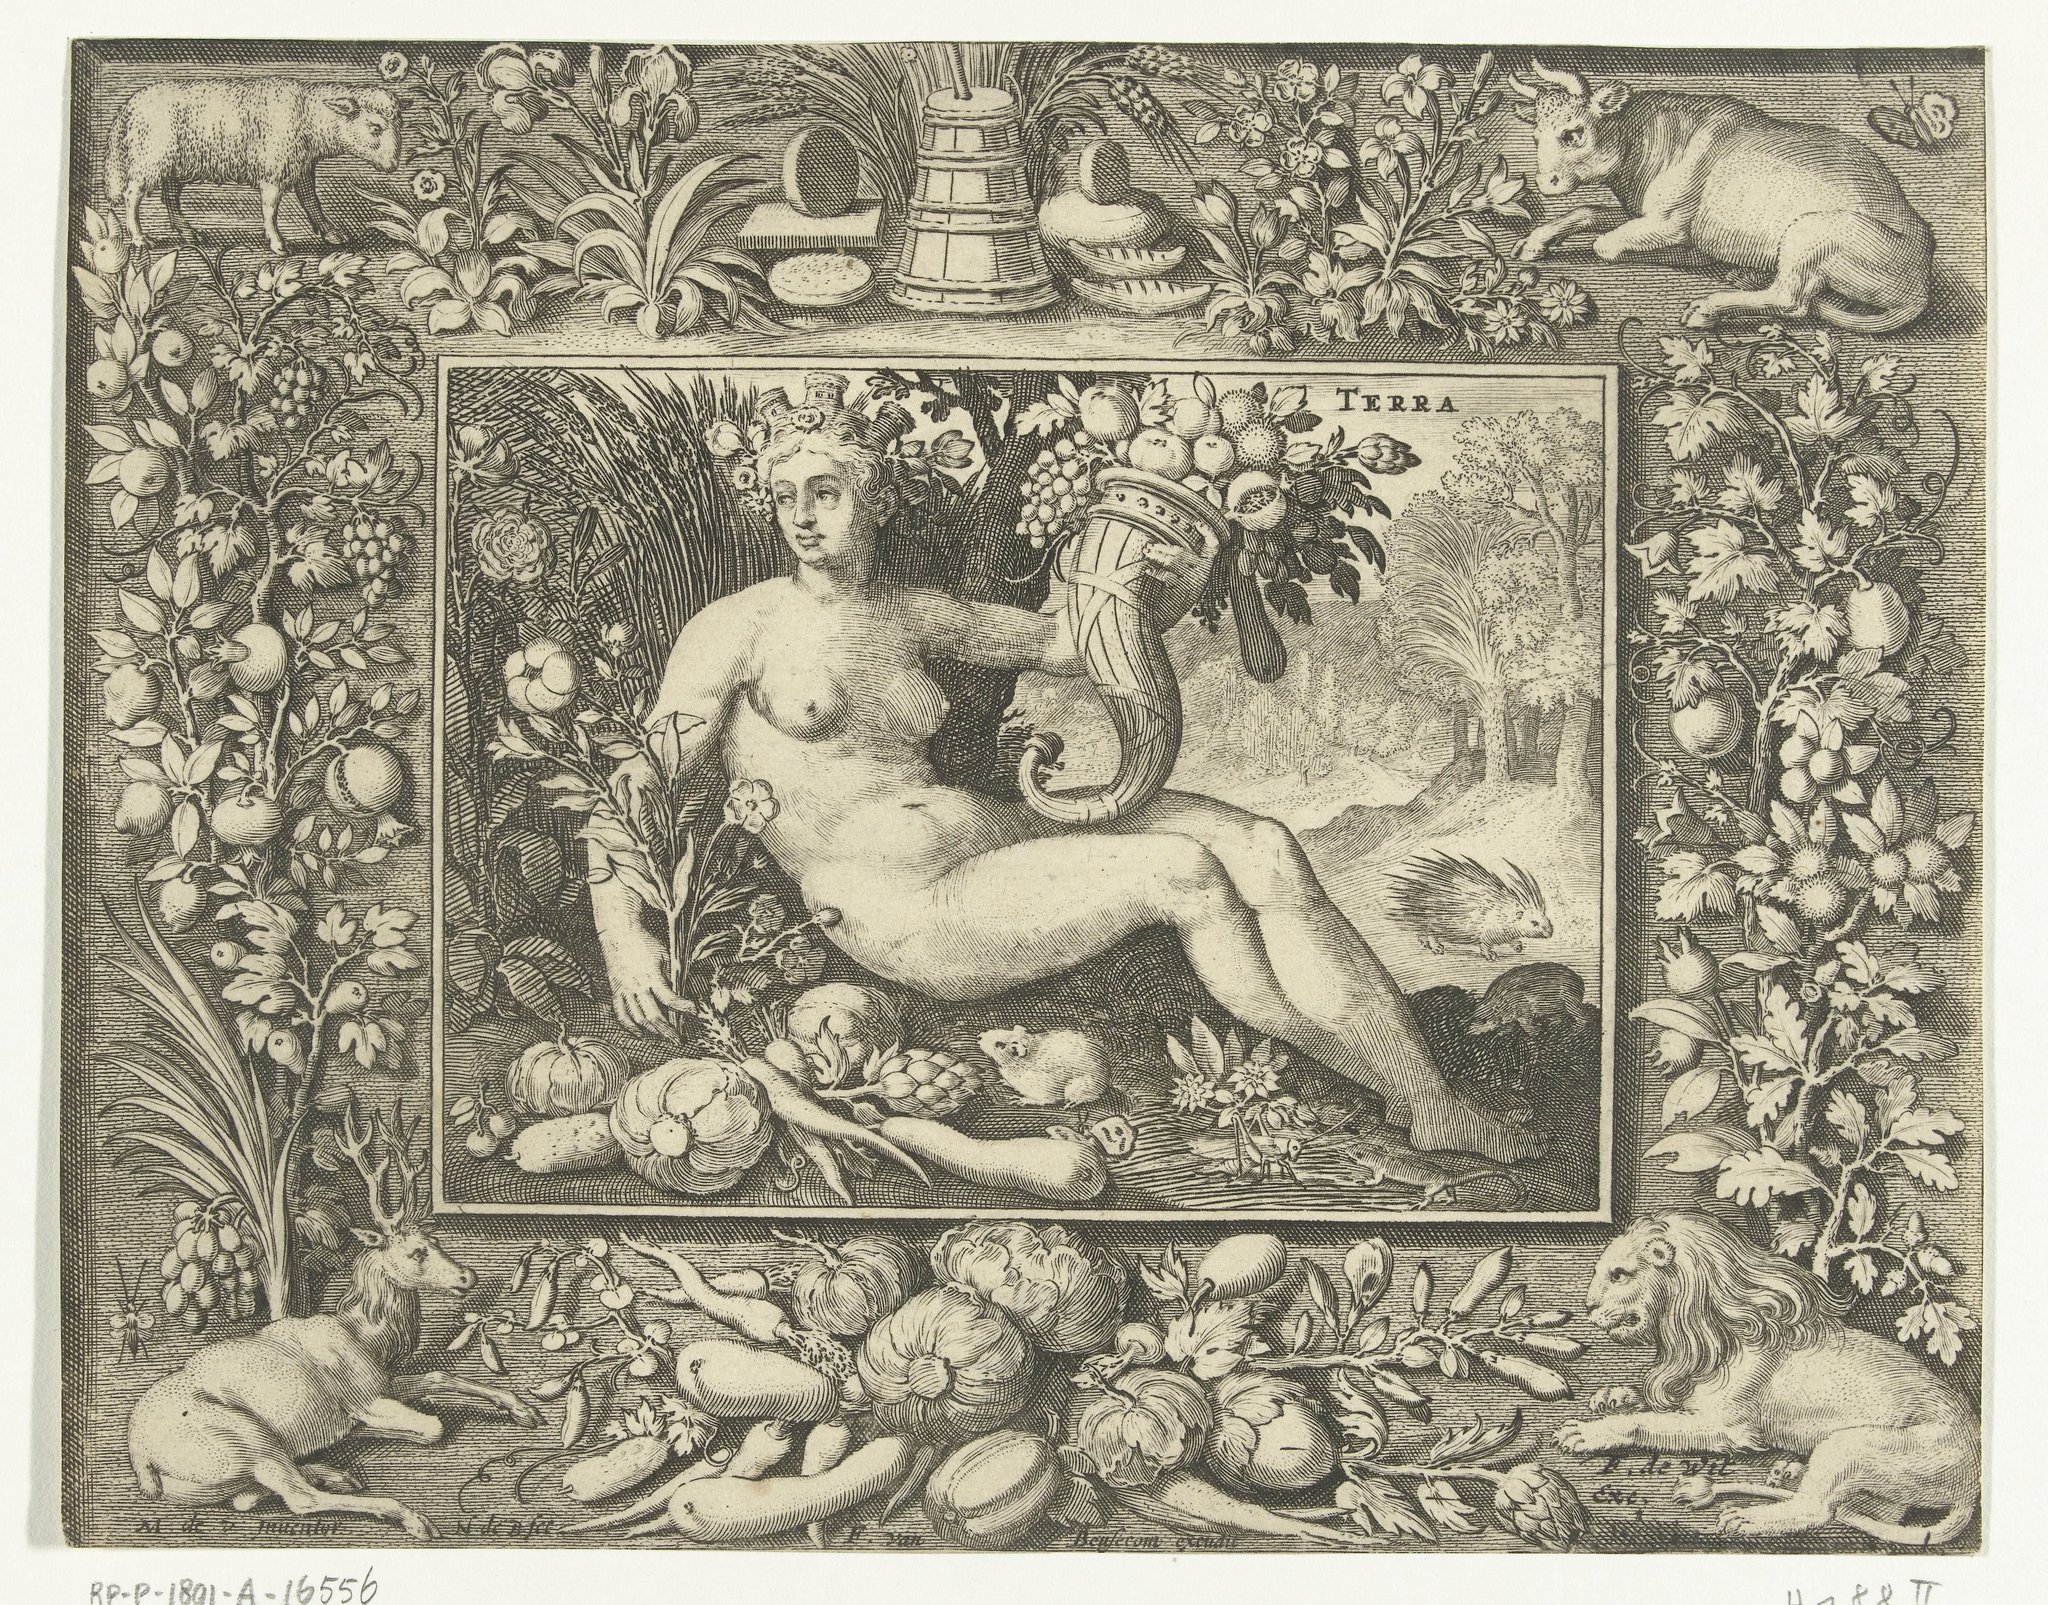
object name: print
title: De vier elementen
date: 1581-1656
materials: paper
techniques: engraving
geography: netherlands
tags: 'cornucopia', horn of plenty, earth (one of the four elements)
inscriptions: collector's mark: Lugt 2228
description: Element aarde als naakte vrouw zittend met hoorn des overvloeds. In een omlijsting met dieren, planten, bloemen, fruit, groente en producten van de landbouw en veeteelt.